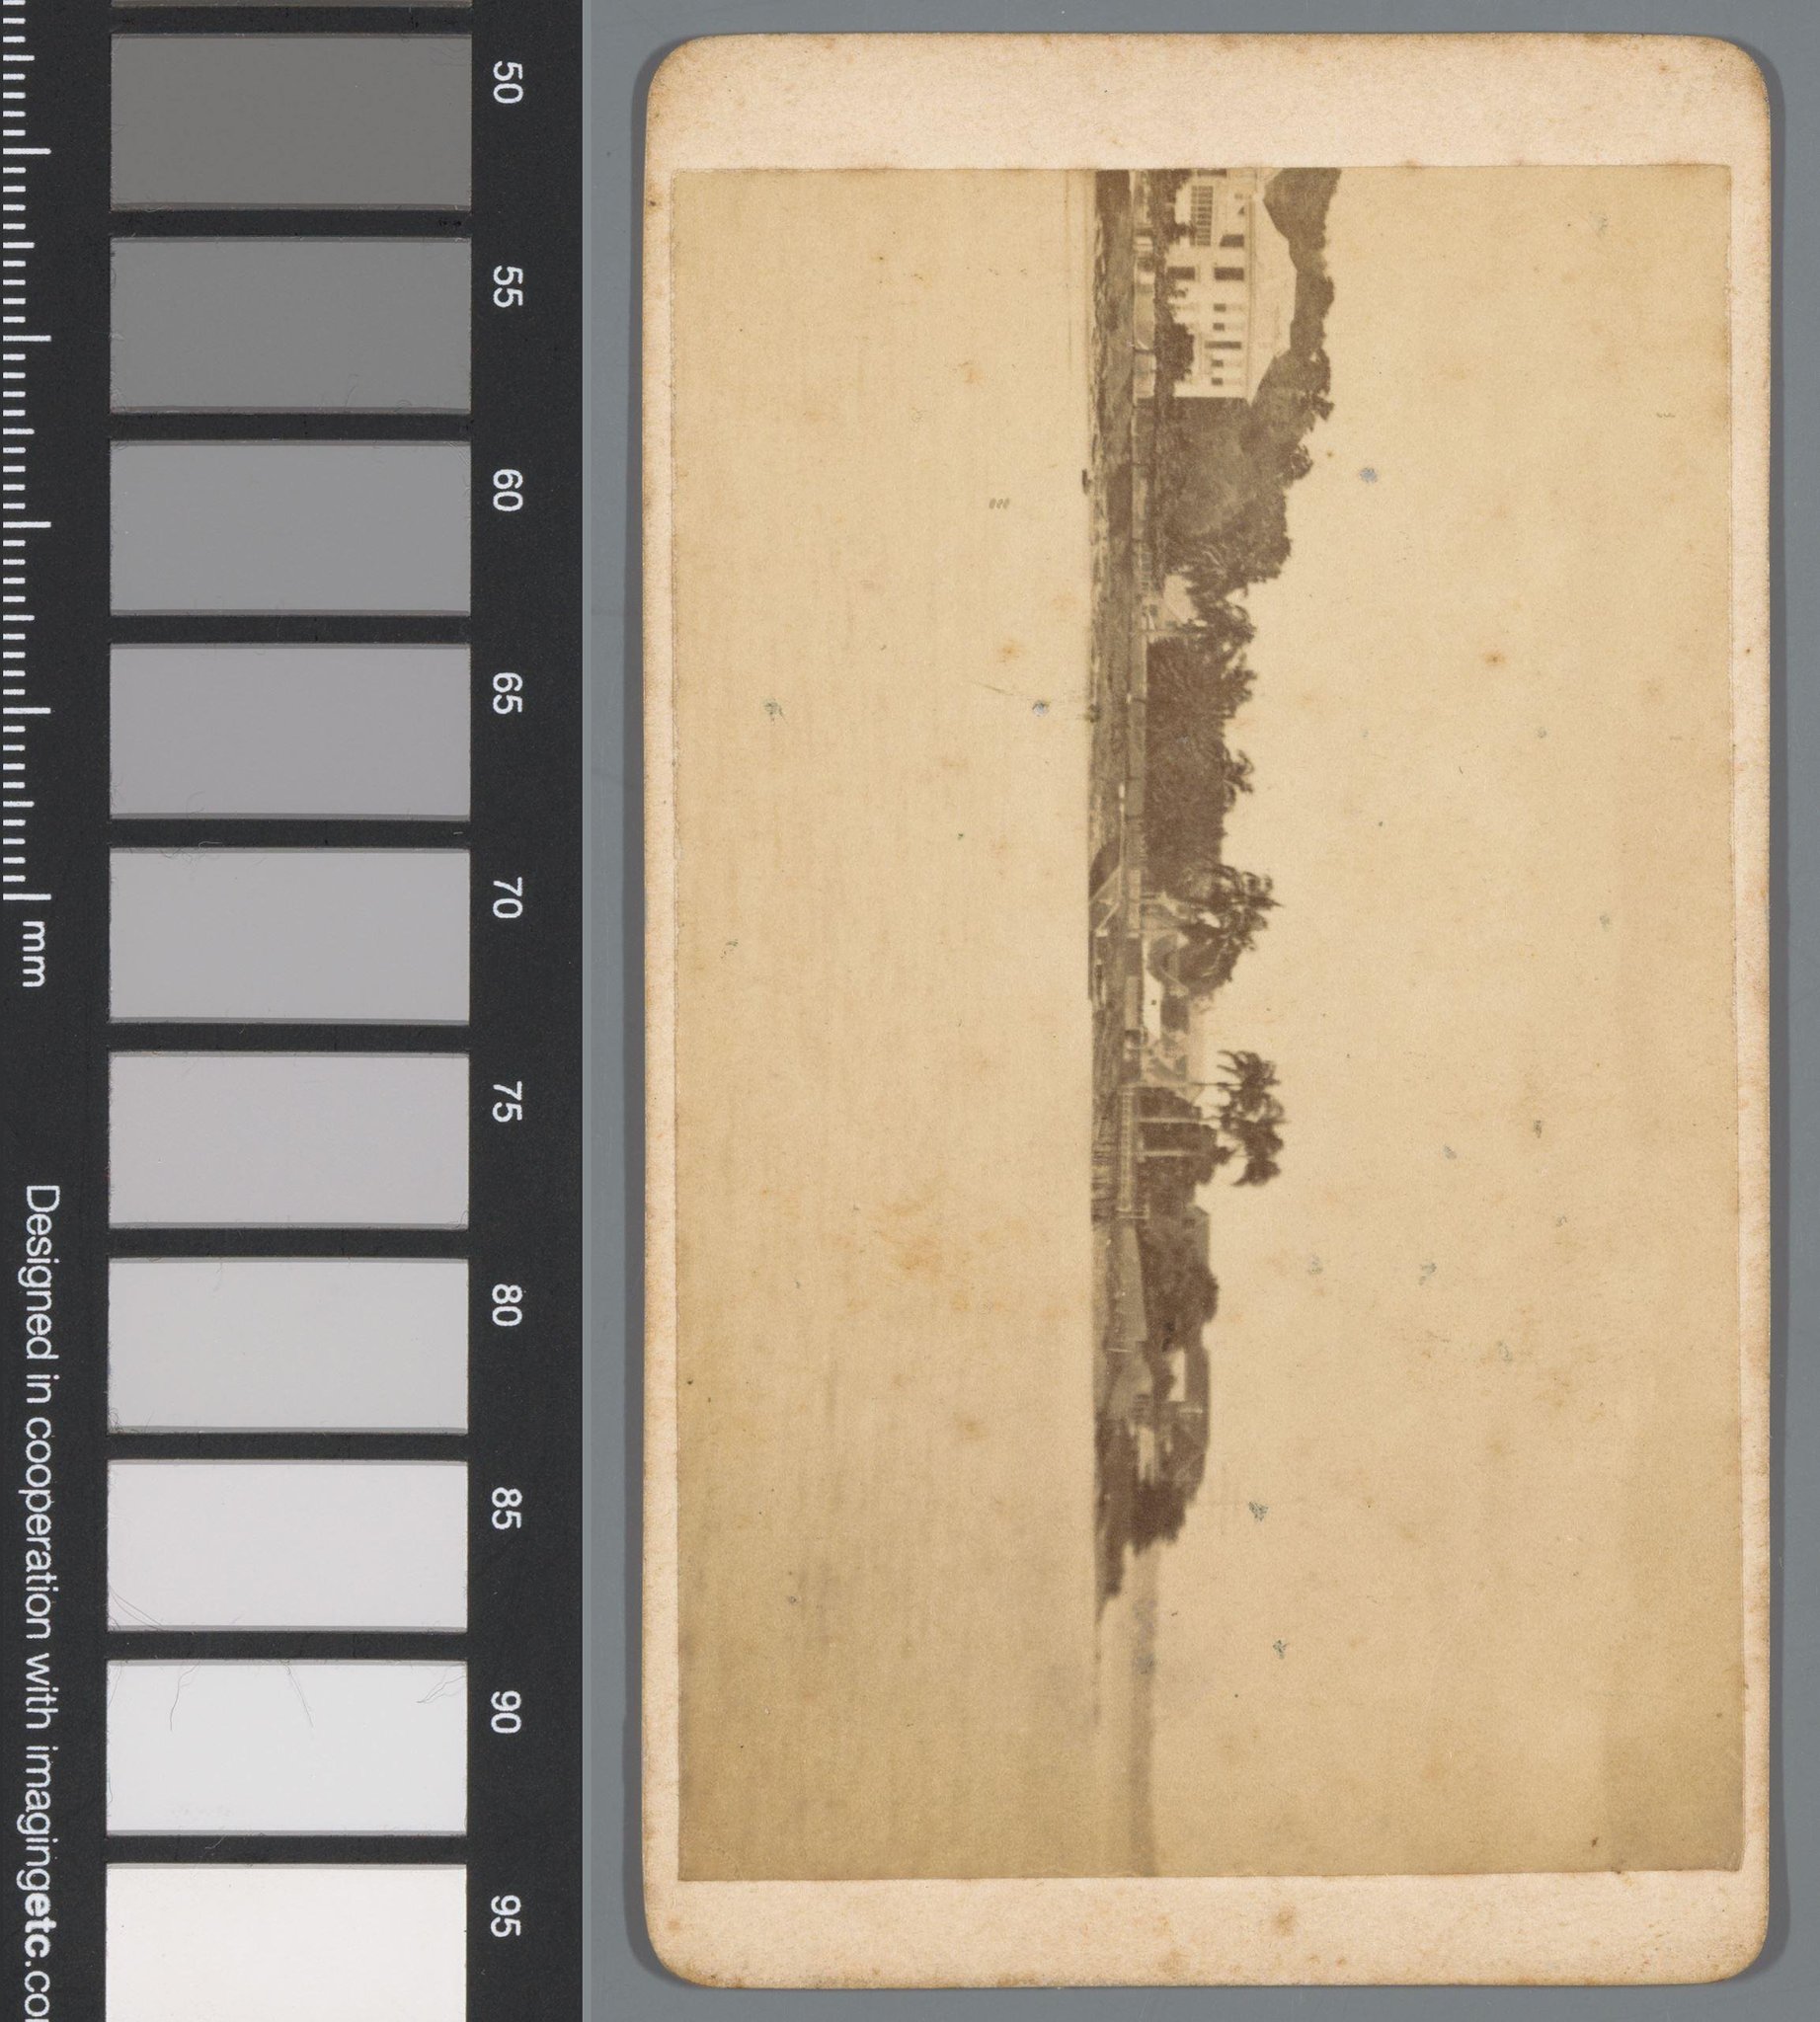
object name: carte de visite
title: Gezicht op de Waterkant, Paramaribo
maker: ferdinand harten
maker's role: publisher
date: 1866-1880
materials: cardboard, paper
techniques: albumen print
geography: paramaribo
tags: coast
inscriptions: signature: ‘Harten’, inscription: ‘Suriname’